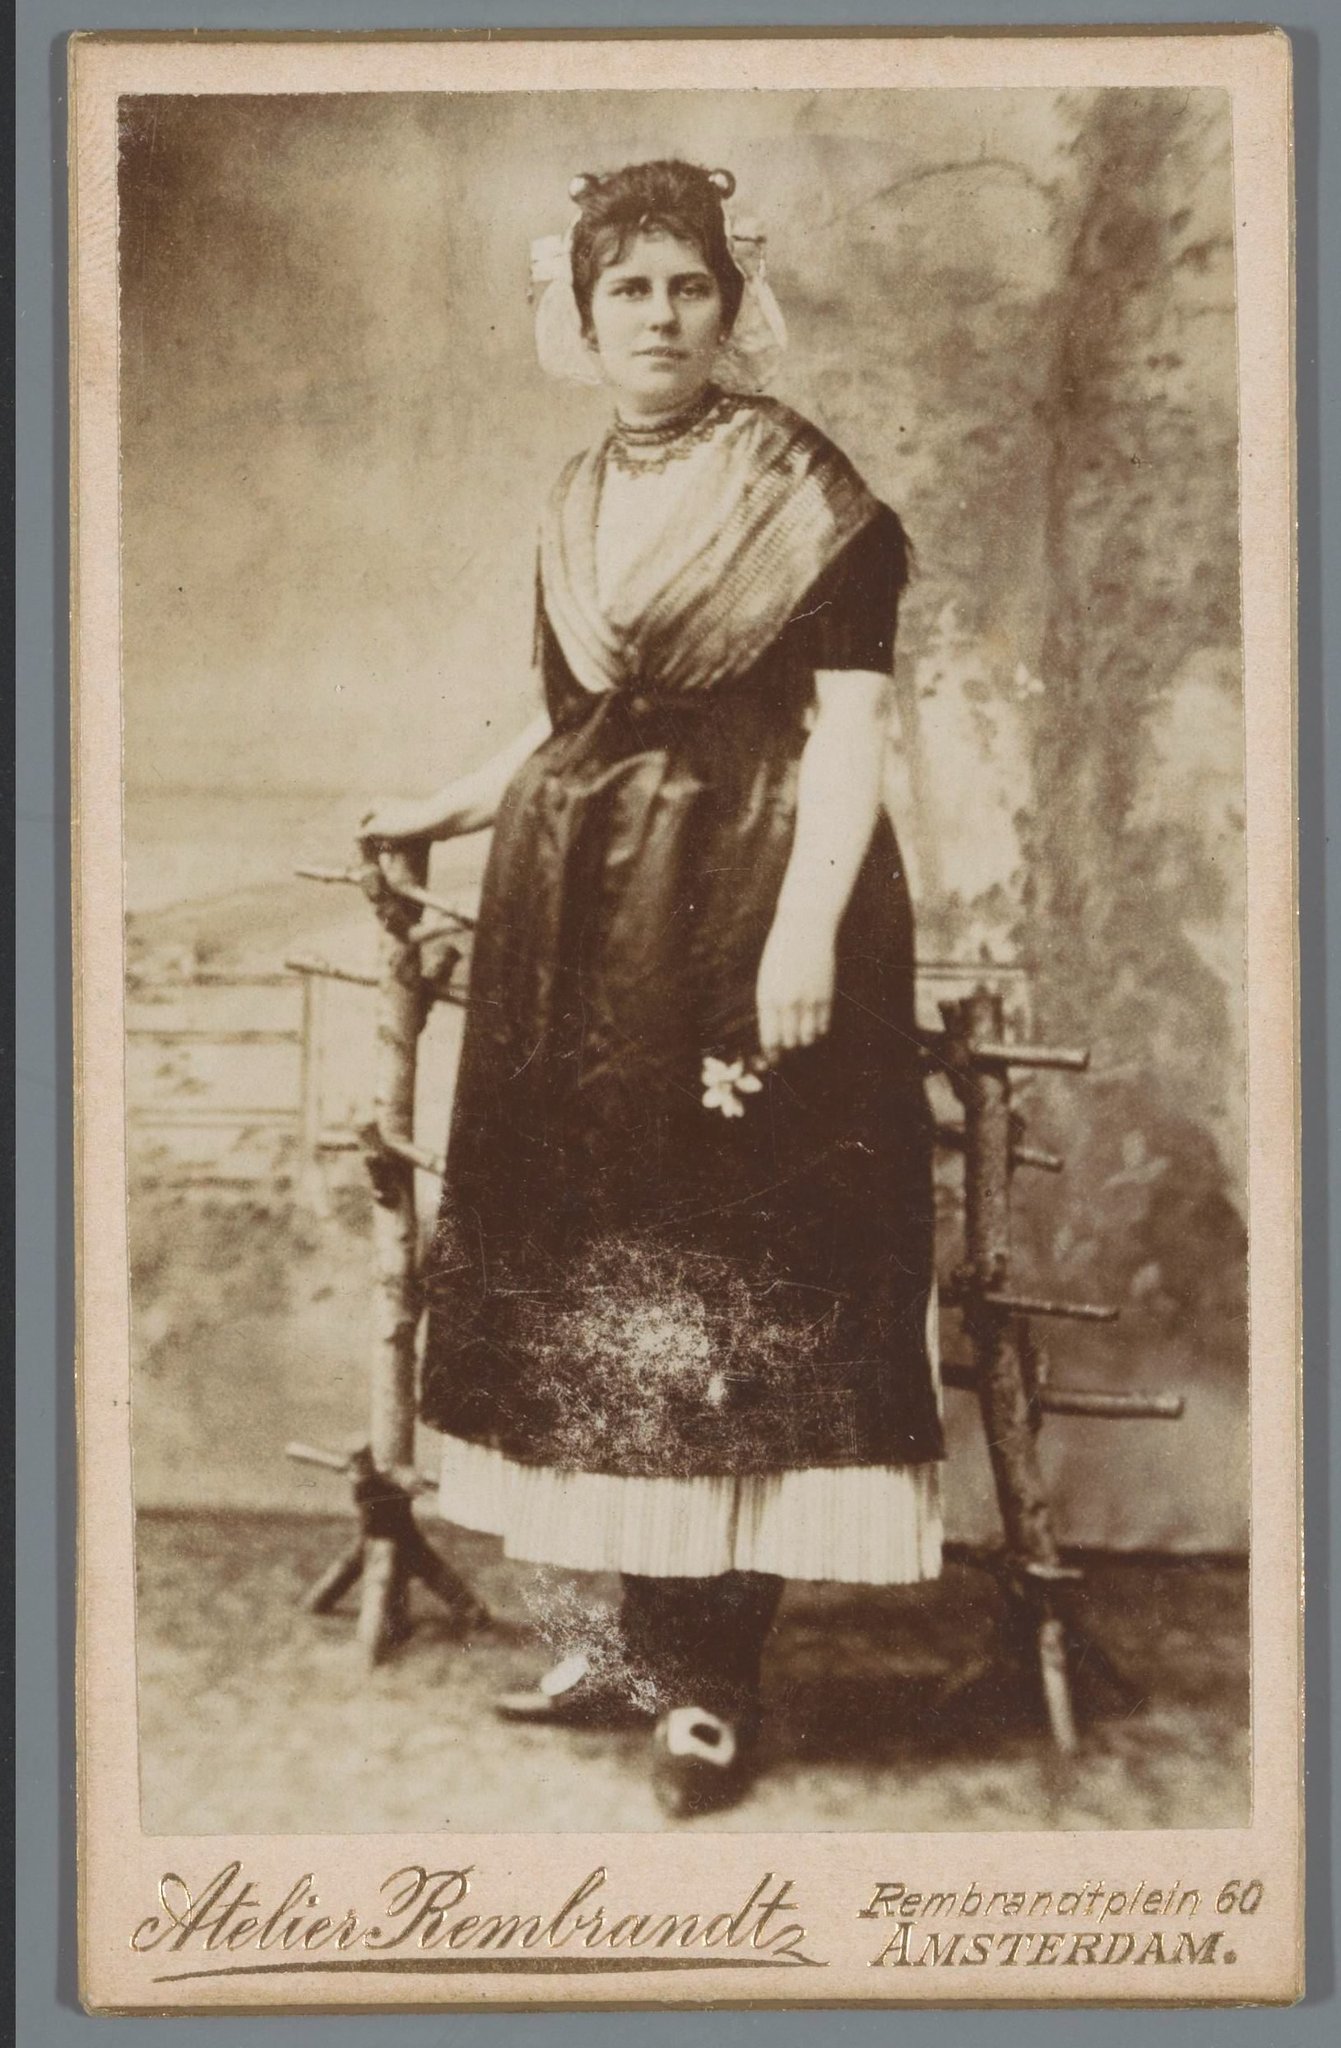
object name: carte de visite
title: Portret van een onbekende vrouw in klederdracht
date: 1897-1902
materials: cardboard, paper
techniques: albumen print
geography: amsterdam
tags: adult woman, anonymous historical person portrayed, folk costume, regional costume, amsterdam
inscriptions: inscription: ‘Atelier Rembrandt/ Rembrandtplein 60/ Amsterdam.’, inscription: ‘Photographie/ Artistique/ Rembrandt/ Amsterdam/ Rembrandtplein 60./ Specialiteit in vergrootingen/ tot levensgroot./ De plaat blijft ter nabestelling/ bewaard./ Trapp & Münch, Berlin.’